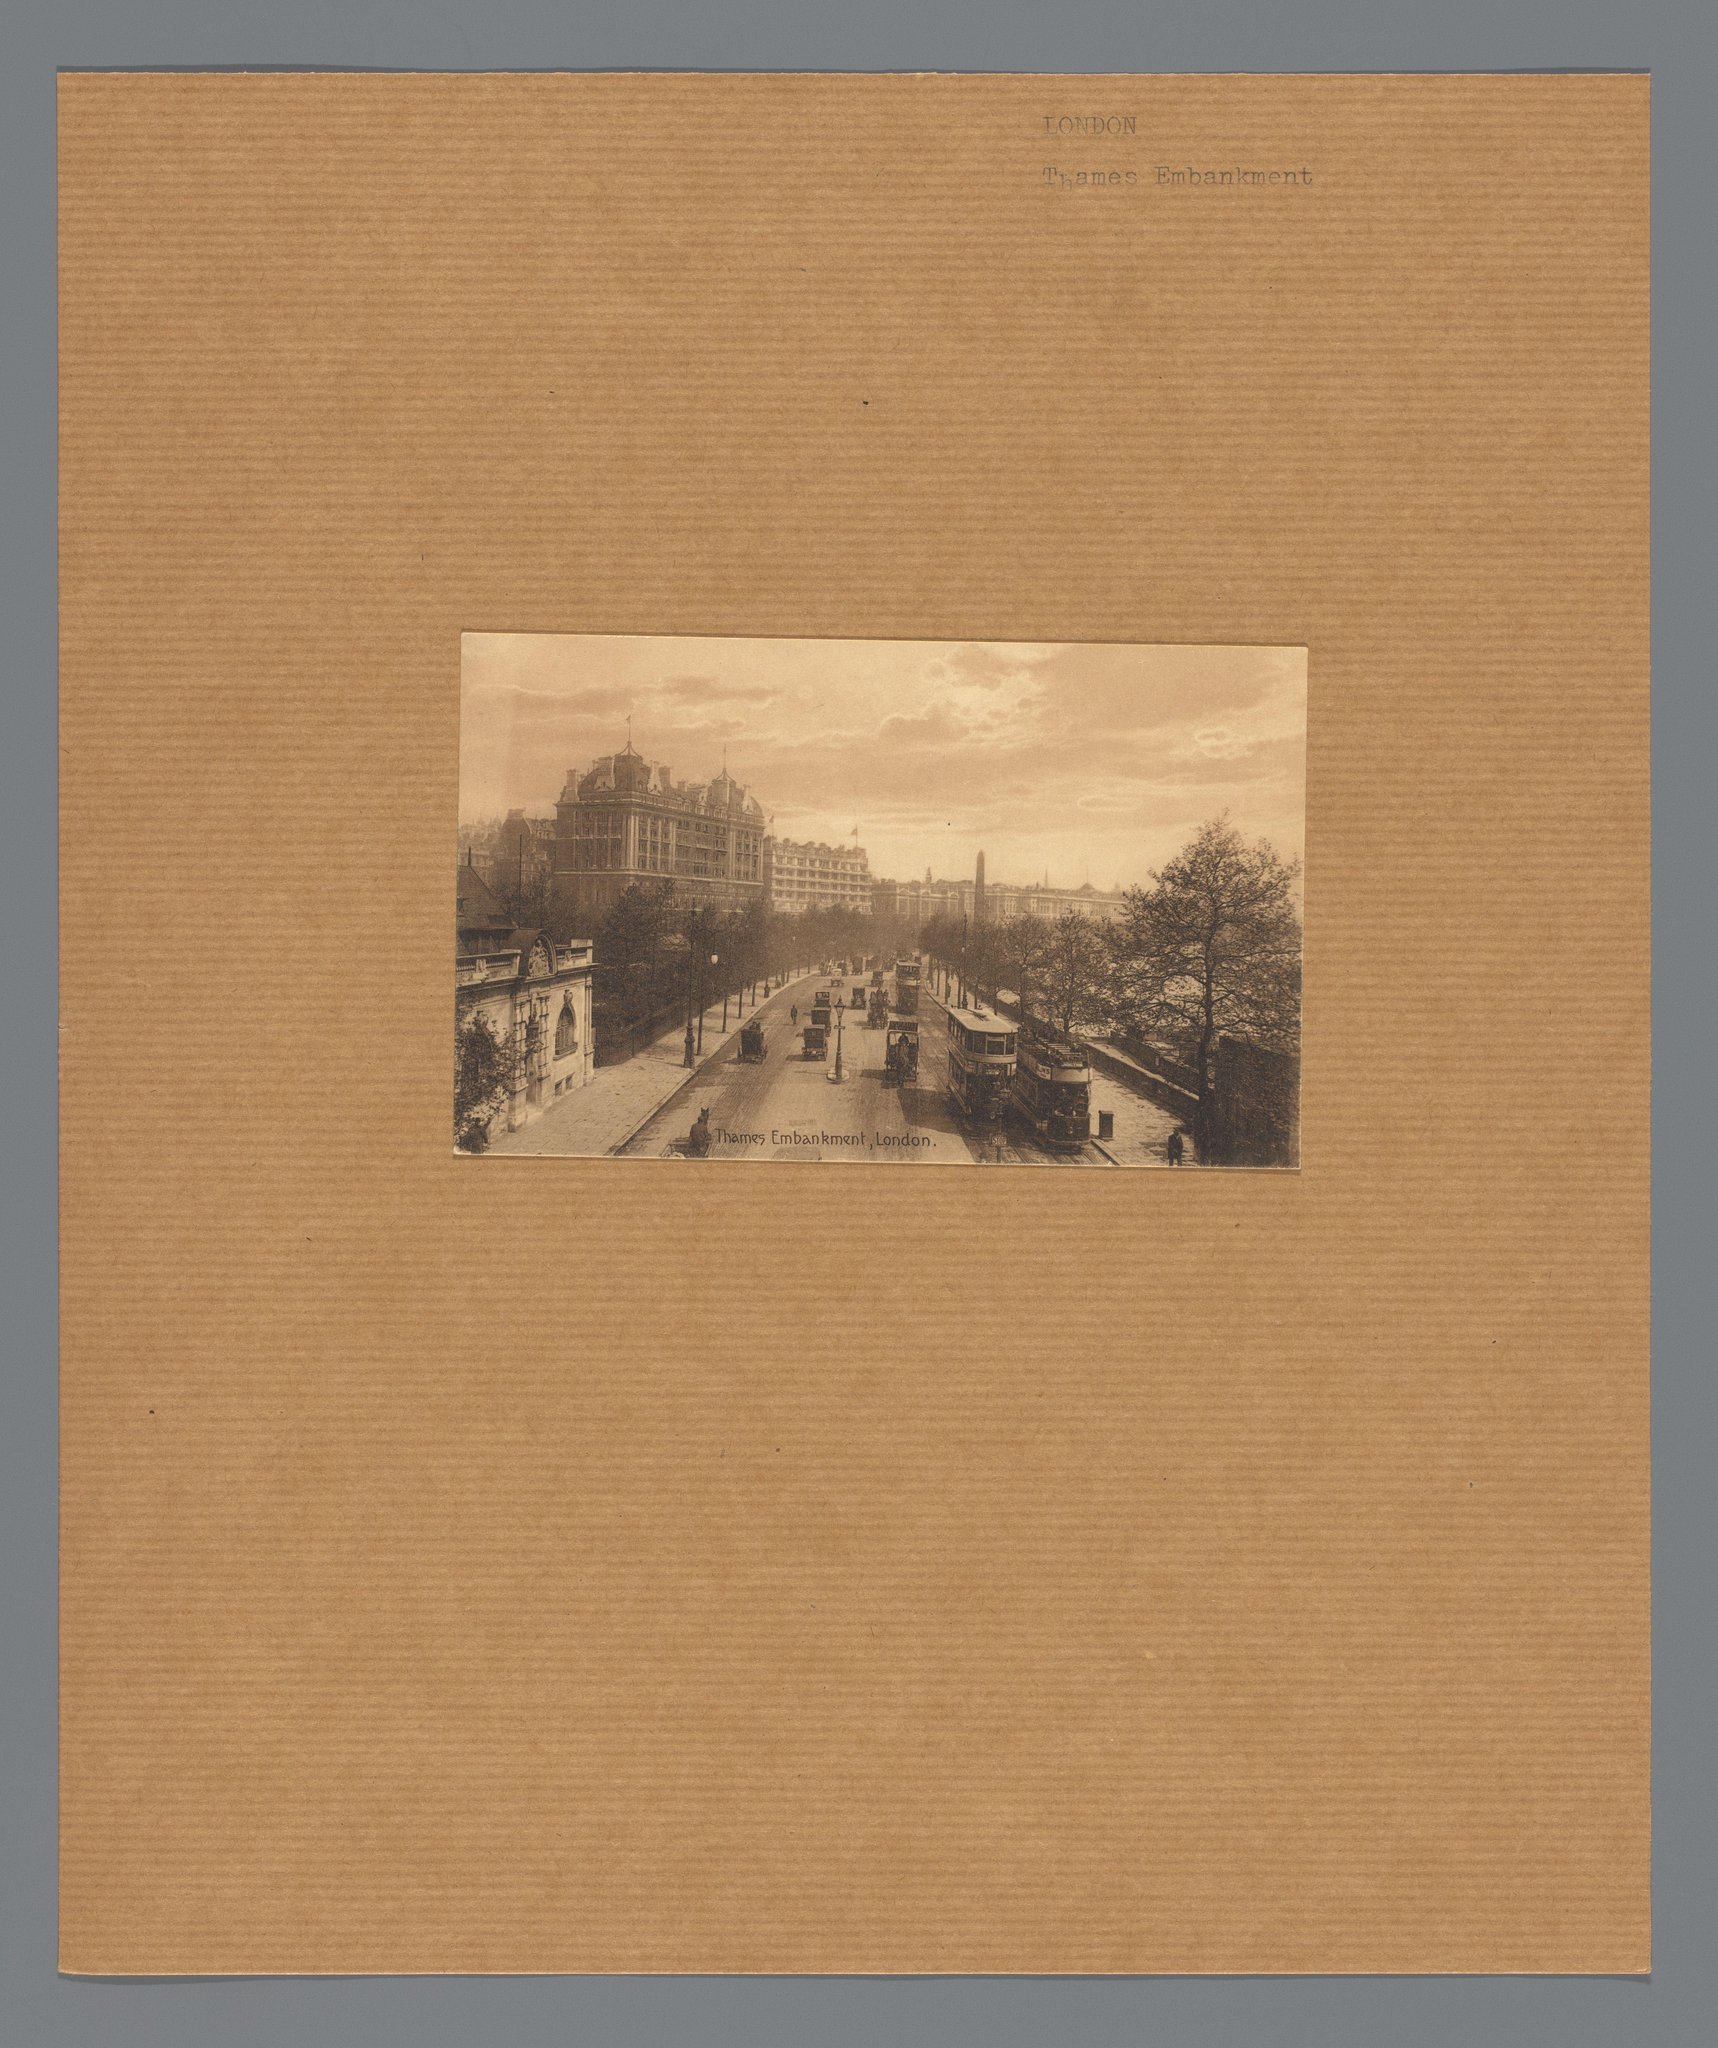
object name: photograph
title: Londen. Thames enbankment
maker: Anonymous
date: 1860-1925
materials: photographic support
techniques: photograph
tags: london, thames